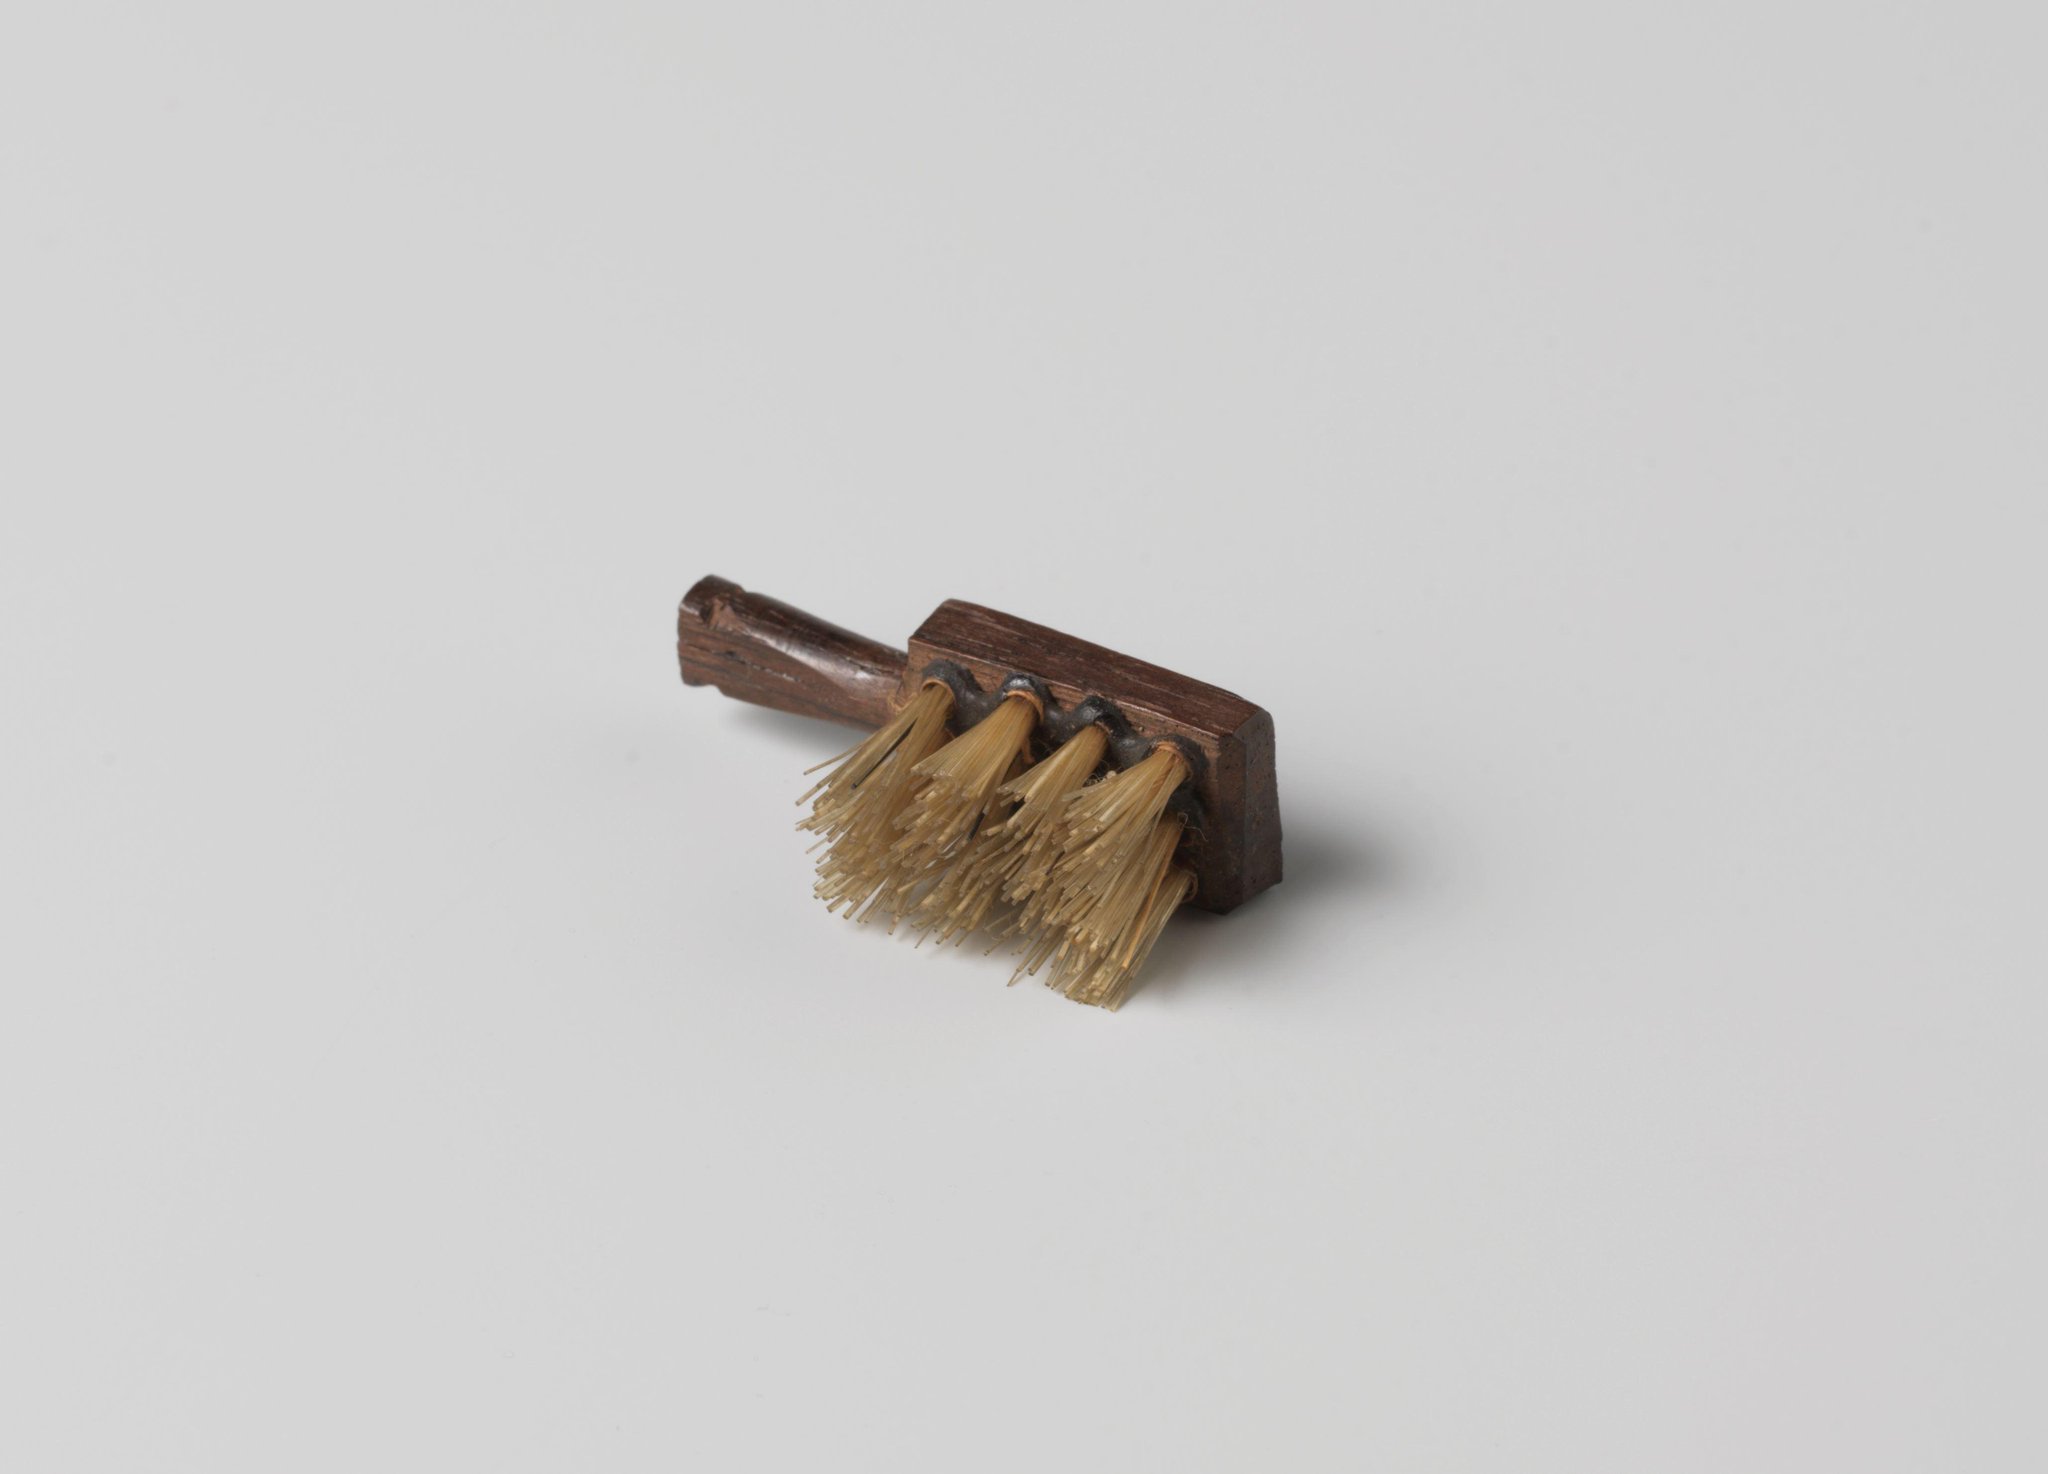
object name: whisk broom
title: Stoffer, met rechthoekige rug en trapeziumvormige steel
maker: Anonymous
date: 1675-1699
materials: wood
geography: amsterdam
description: Een stoffer van palissanderhout en varkenshaar; rechthoekige rug en trapeziumvormige steel, met bovenaan kleine inkepingen (voor touw?).